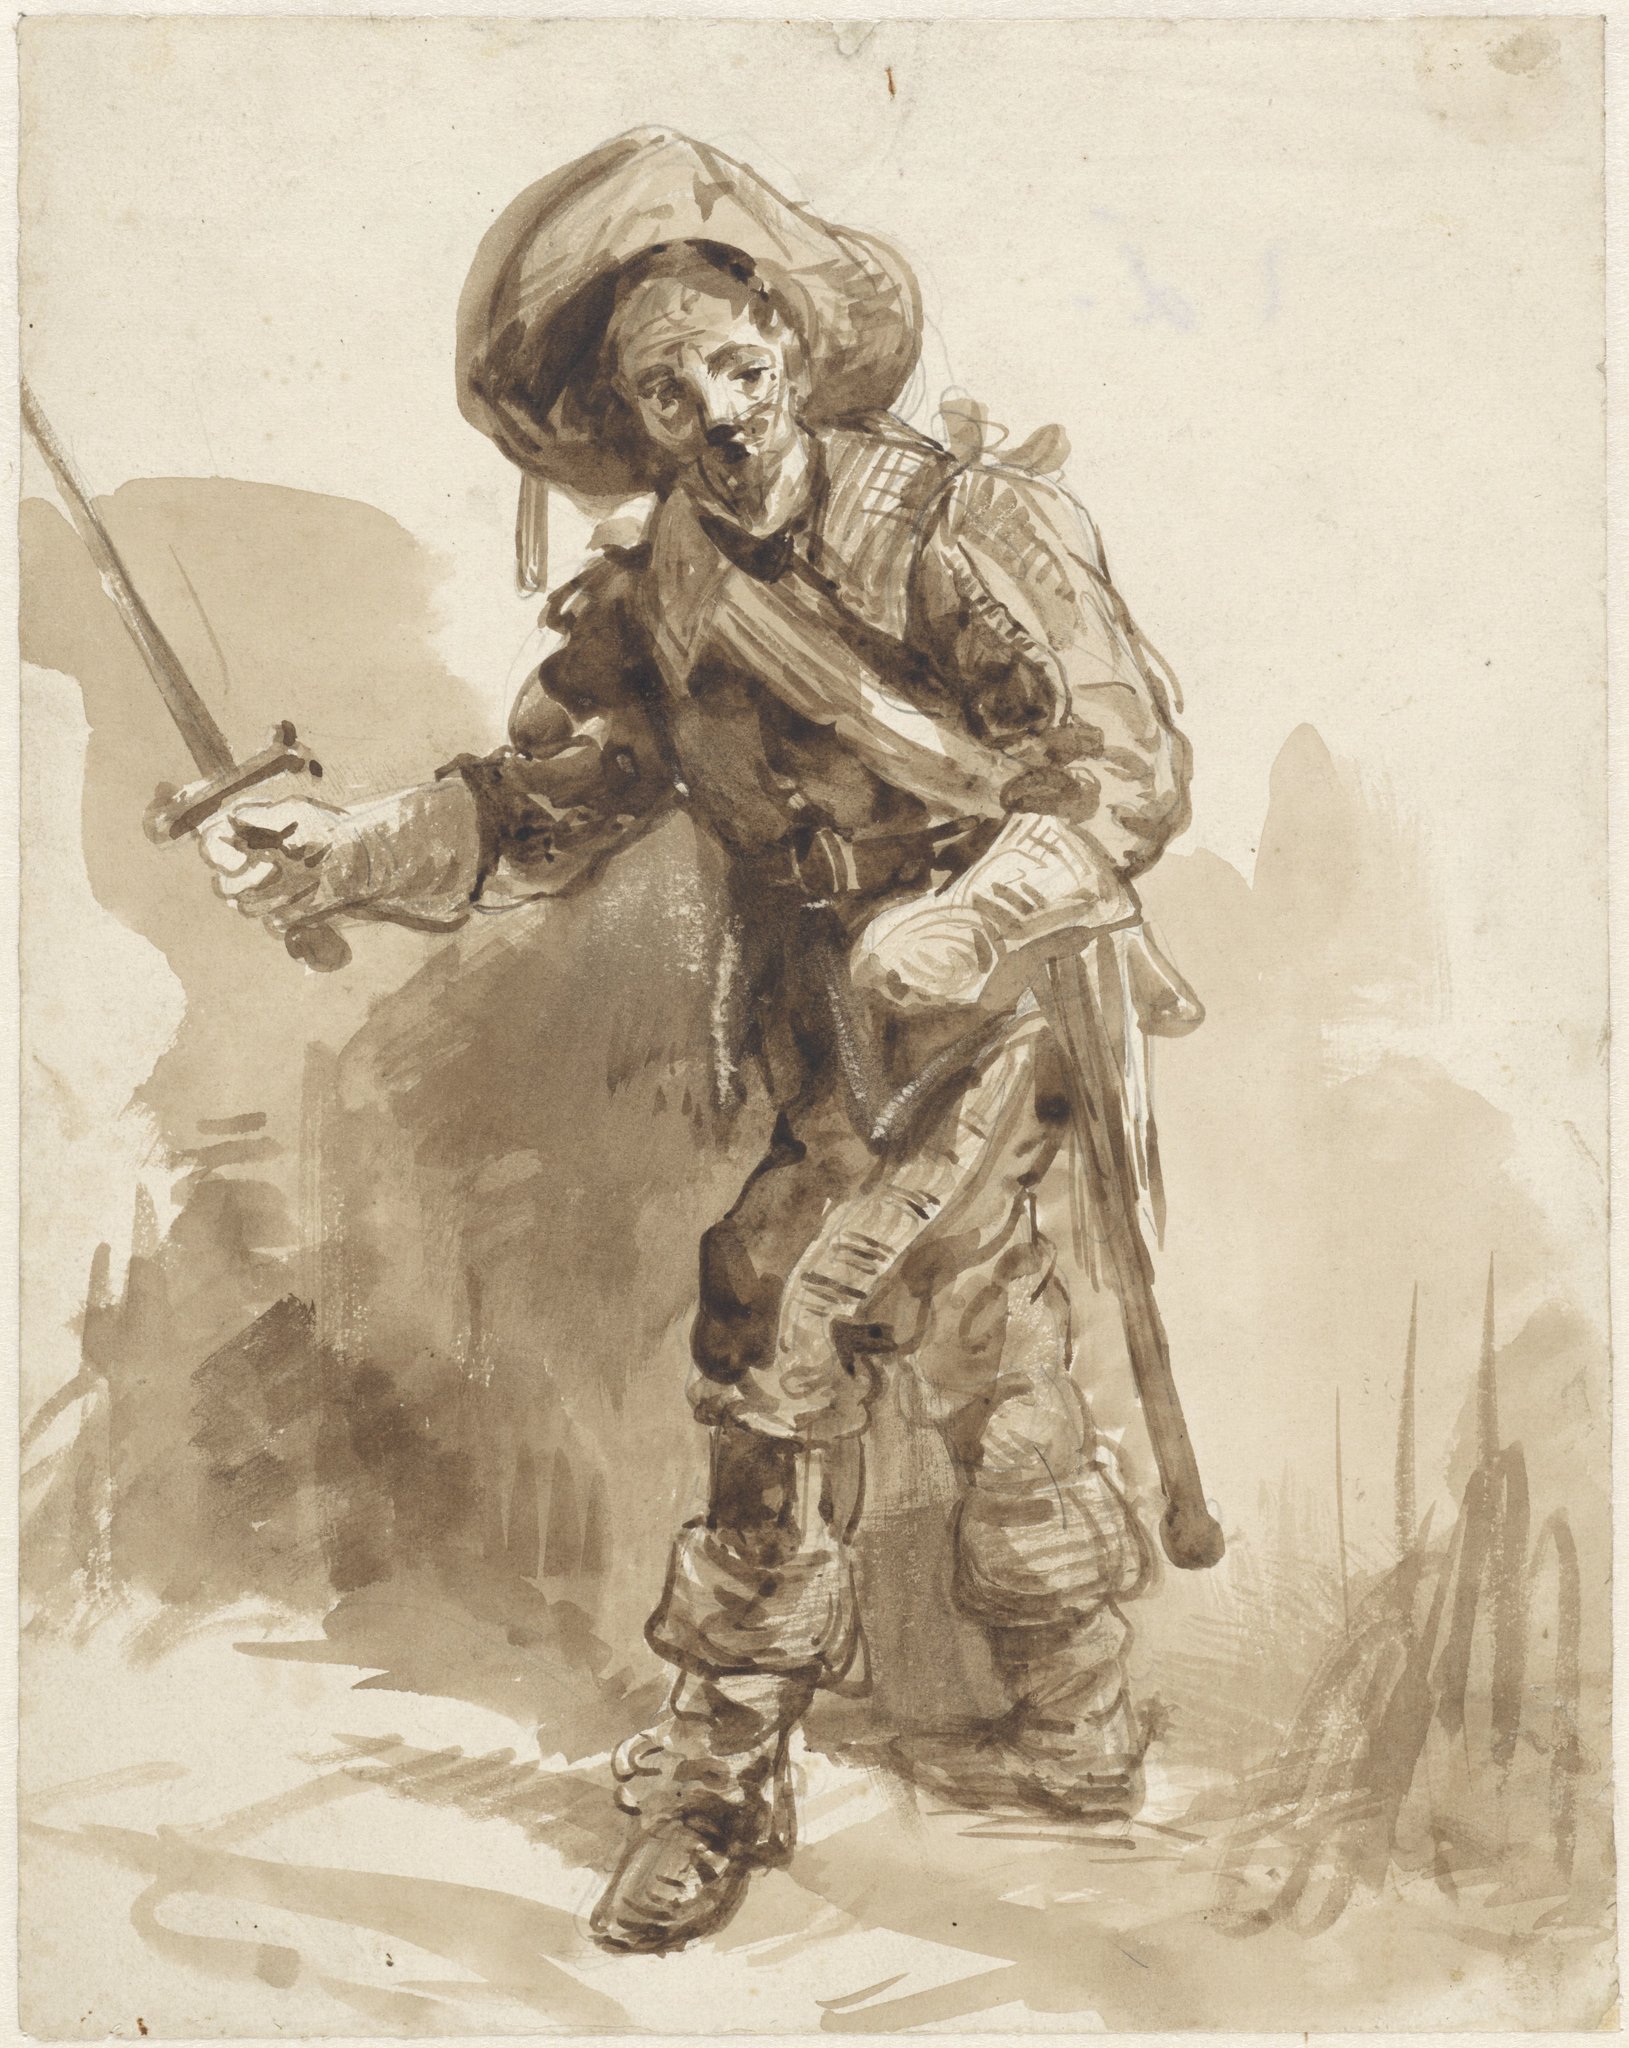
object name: drawing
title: Krijgsman met getrokken zwaard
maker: jacobus pelgrom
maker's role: draughtsman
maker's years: 1811-1861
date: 1821-1861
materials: paper, pencil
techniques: brush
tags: private soldier